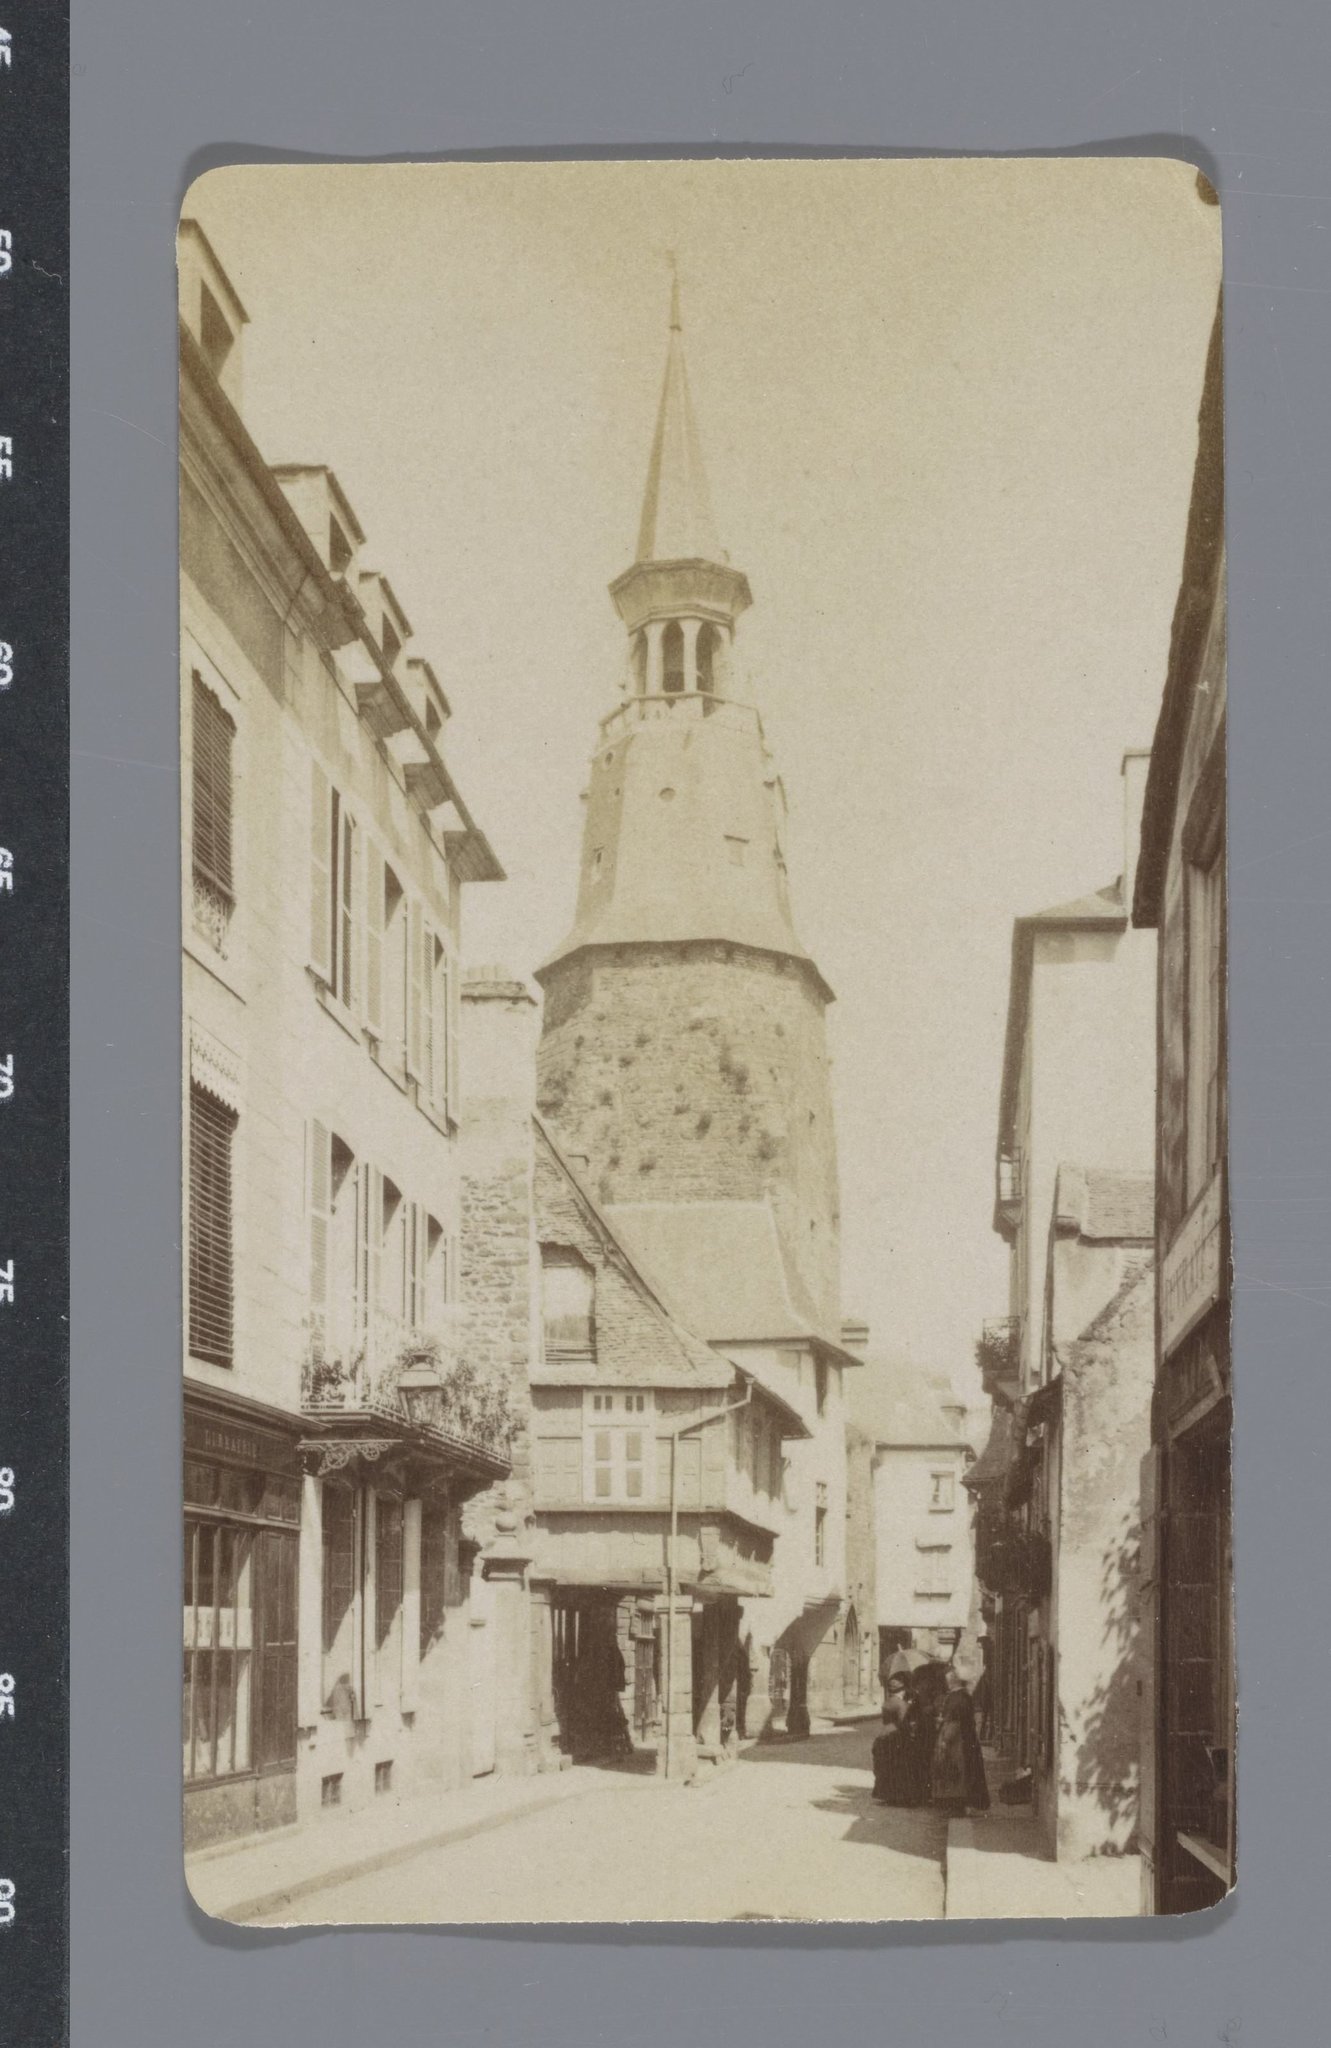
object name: photograph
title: Klokkentoren in Dinan, Frankrijk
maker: Anonymous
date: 1851-1900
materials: paper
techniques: albumen print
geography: dinan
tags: tower, clock tower ~ monumental adornment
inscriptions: inscription: ‘Dinan, Tour d'Horloge’